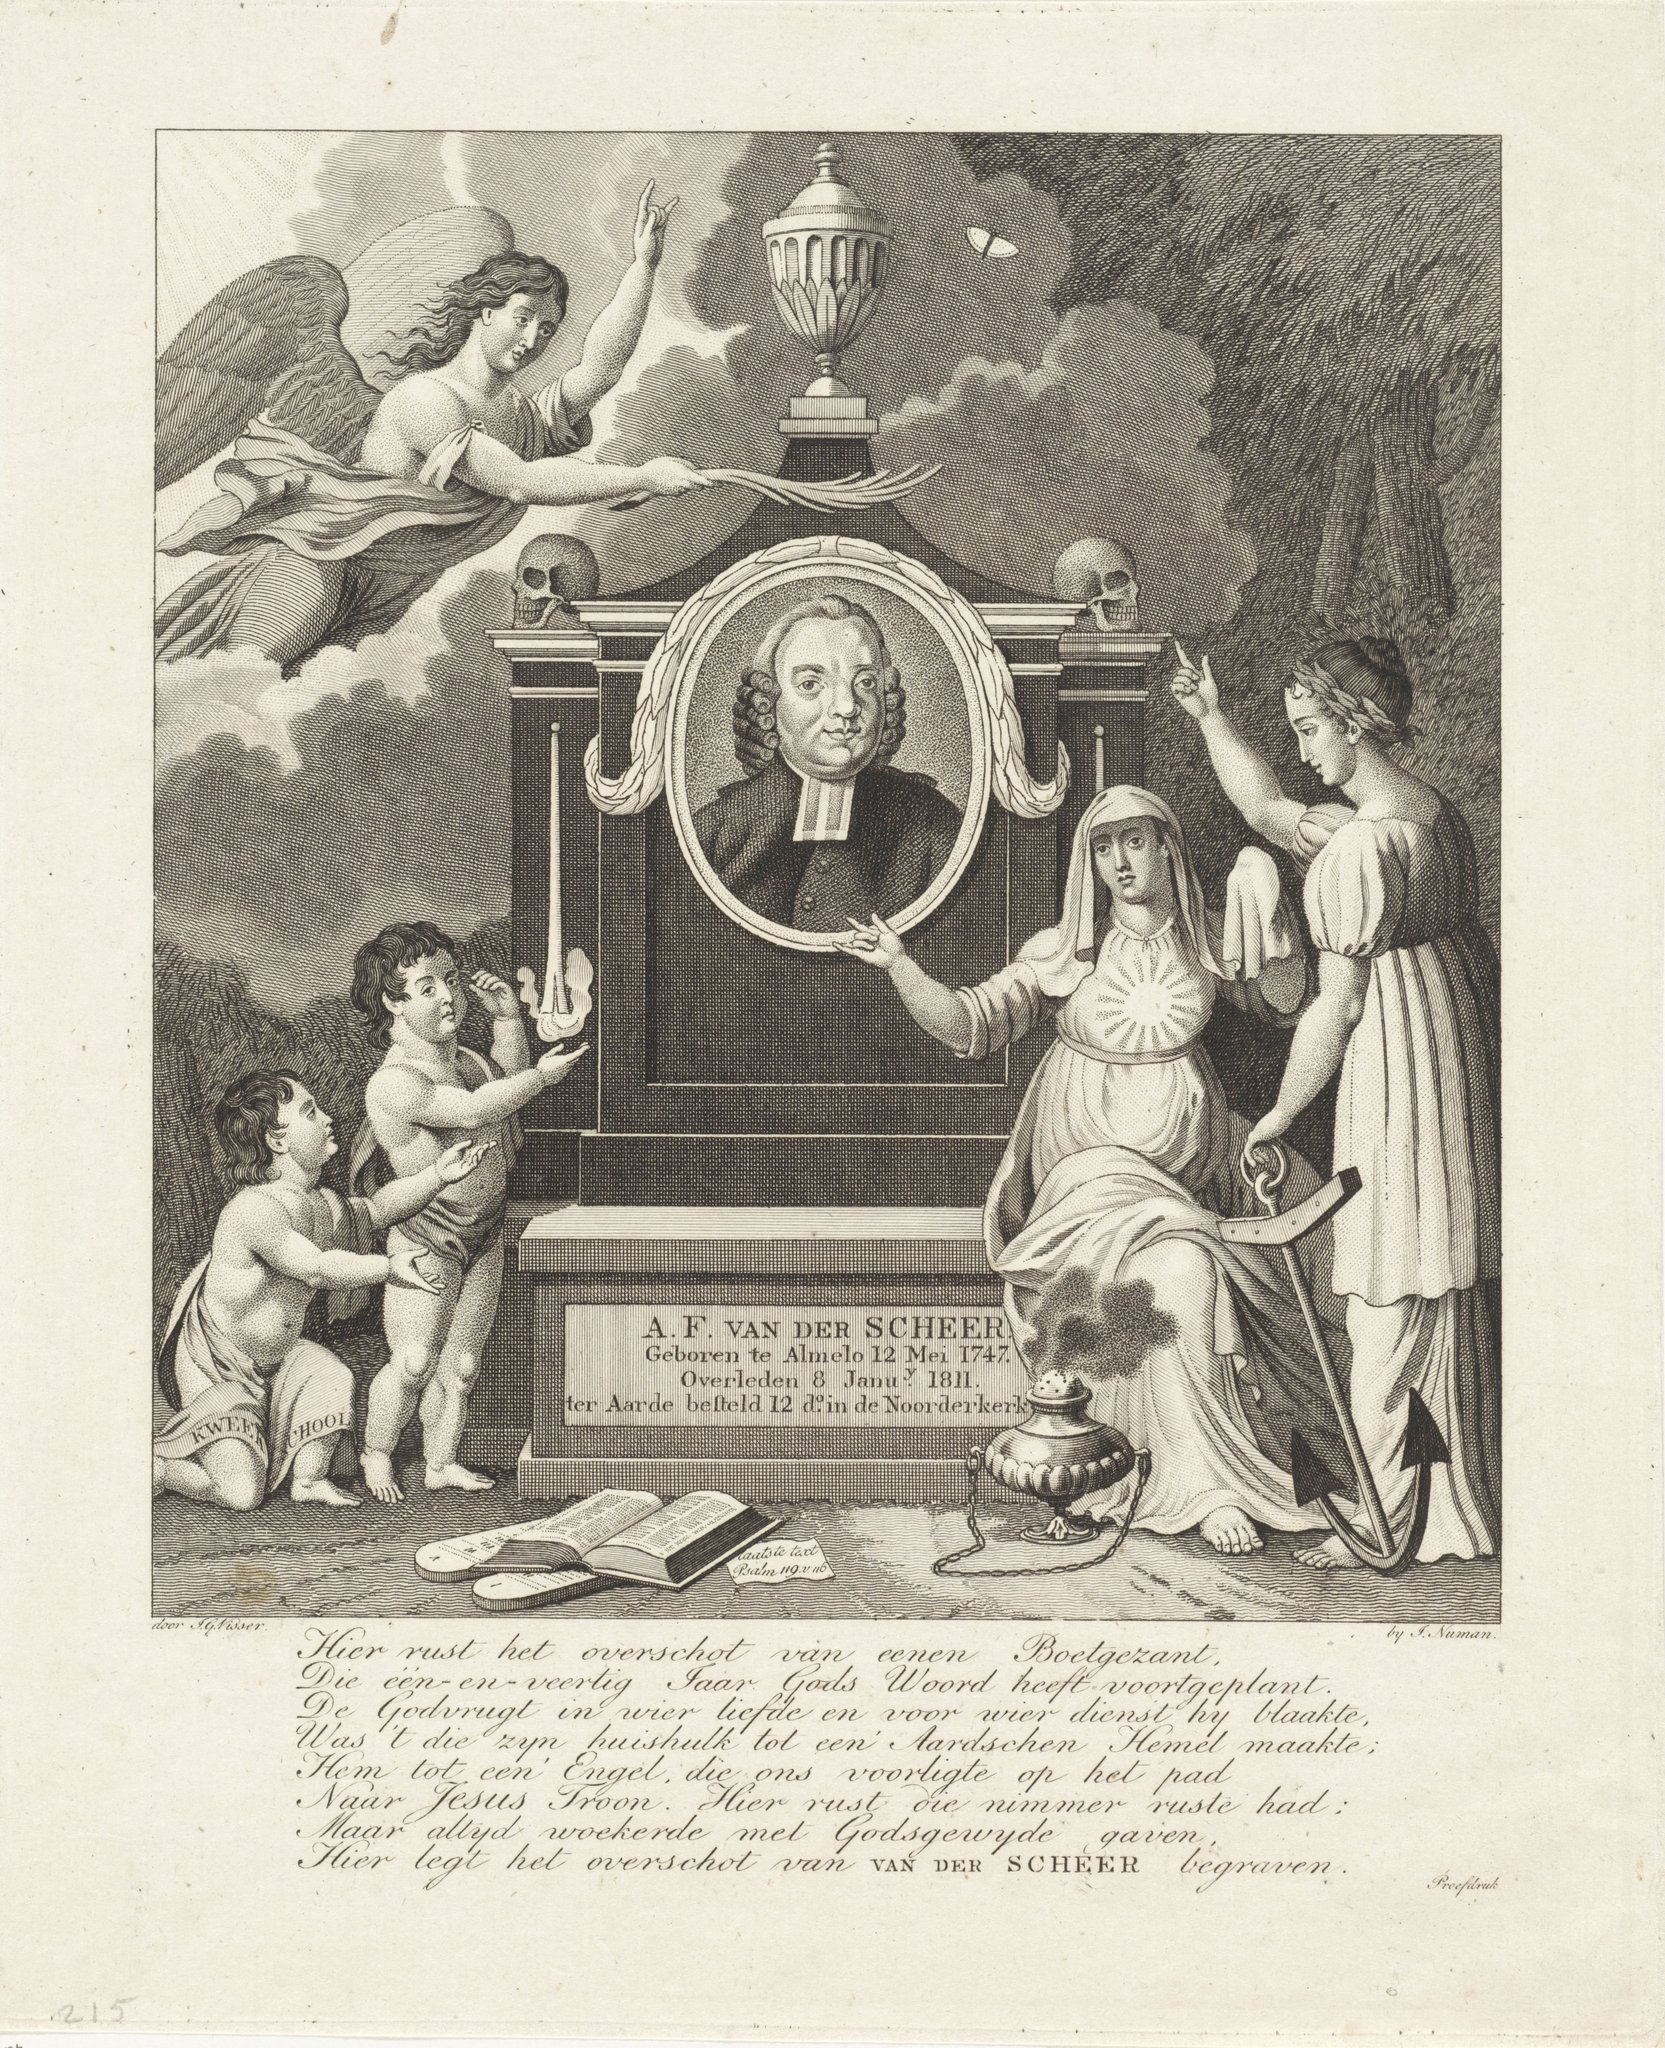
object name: print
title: Allegorisch grafmonument voor Adolf Frederik van der Scheer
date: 1811-1813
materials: paper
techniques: engraving, etching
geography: amsterdam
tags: hope, 'spes'; 'speranza divina e certa' (ripa) ~ one of the three theological virtues, grave-building, monumental tomb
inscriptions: collector's mark: Lugt 2228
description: Herdenkingsmonument voor de predikant Adolf Frederik van der Scheer. Rechts een allegorische vrouwenfiguur met een stralenkrans op haar borst, bij de personificatie van de hoop, met een anker. Boven het portret een engel met een lauwerkrans.